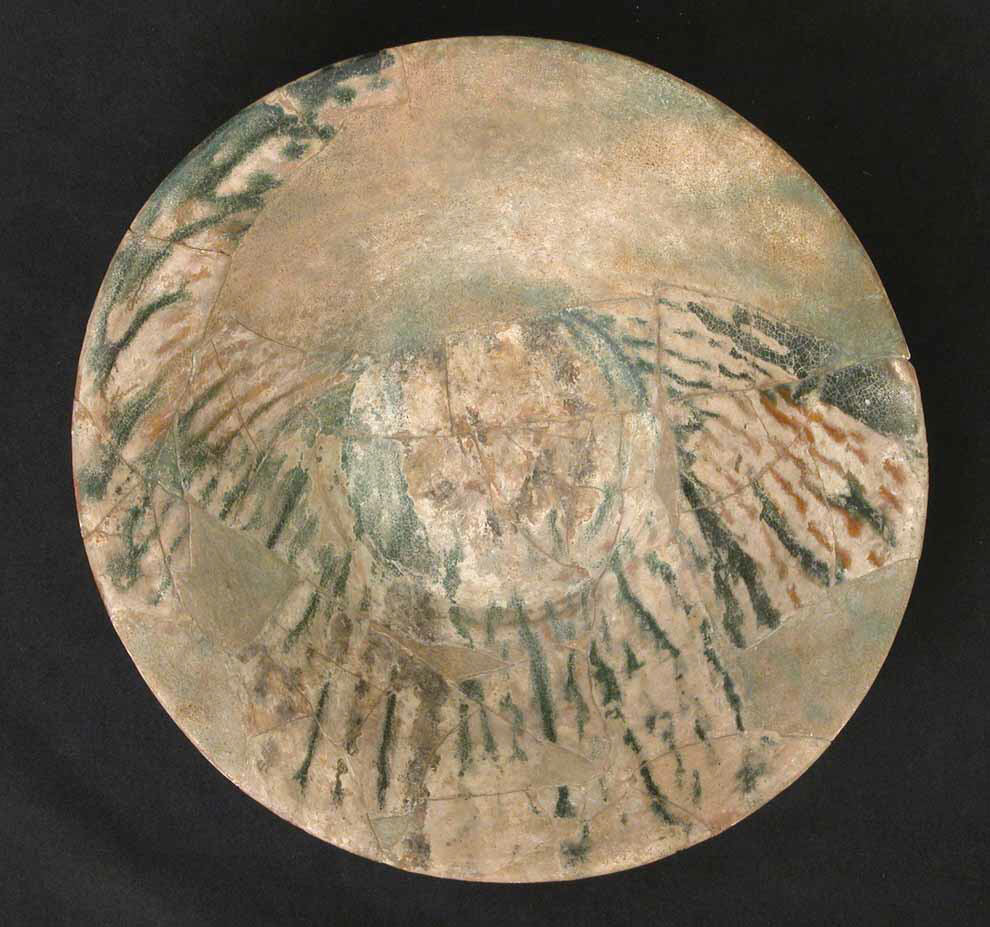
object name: bowl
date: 701-900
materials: earthenware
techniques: glazing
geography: iran